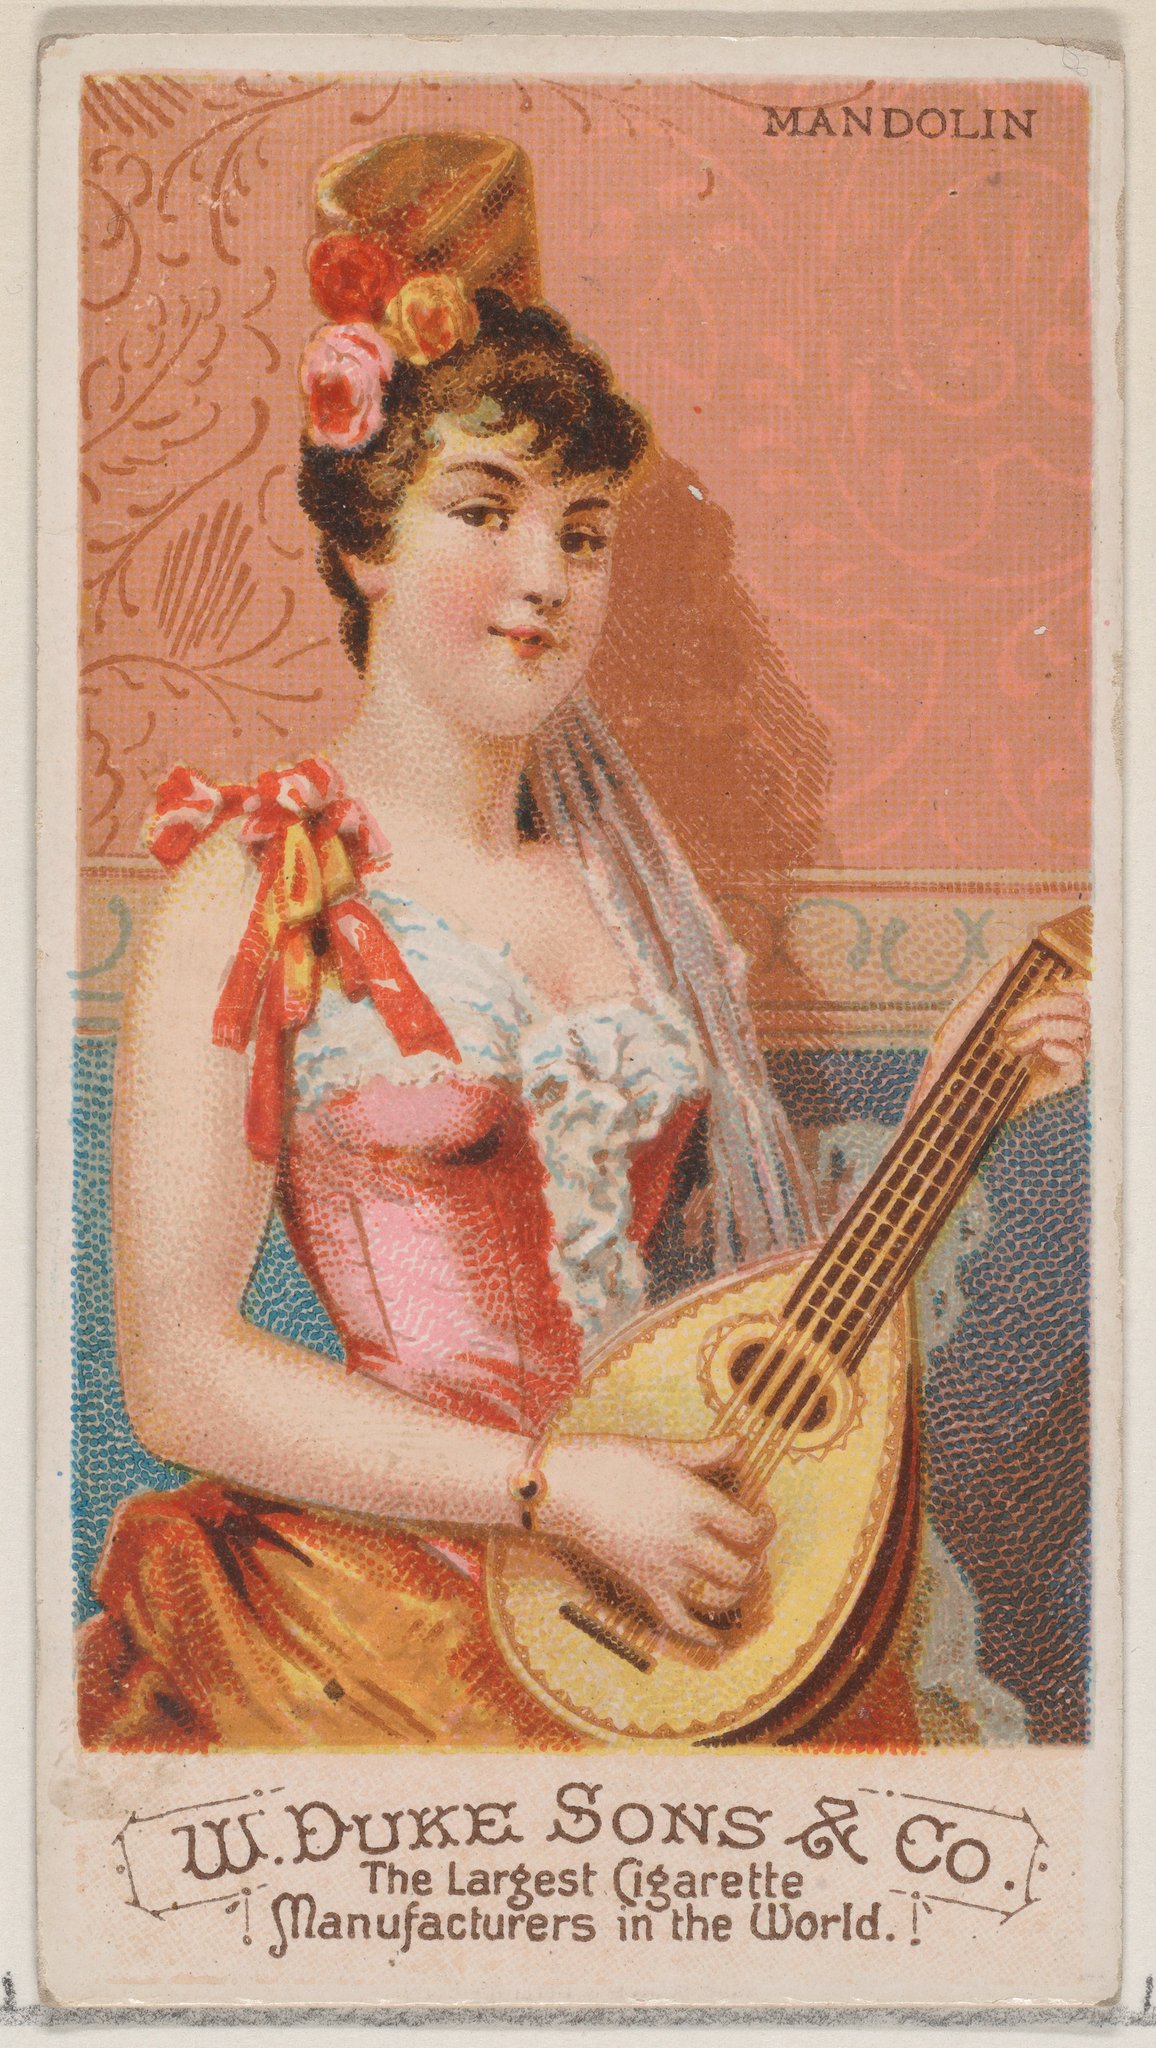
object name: print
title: Mandolin, from the Musical Instruments series (N82) for Duke brand cigarettes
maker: w. duke, sons & co.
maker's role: publisher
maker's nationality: american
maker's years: 1870-1920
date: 1888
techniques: color lithograph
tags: musical instruments,women,musicians